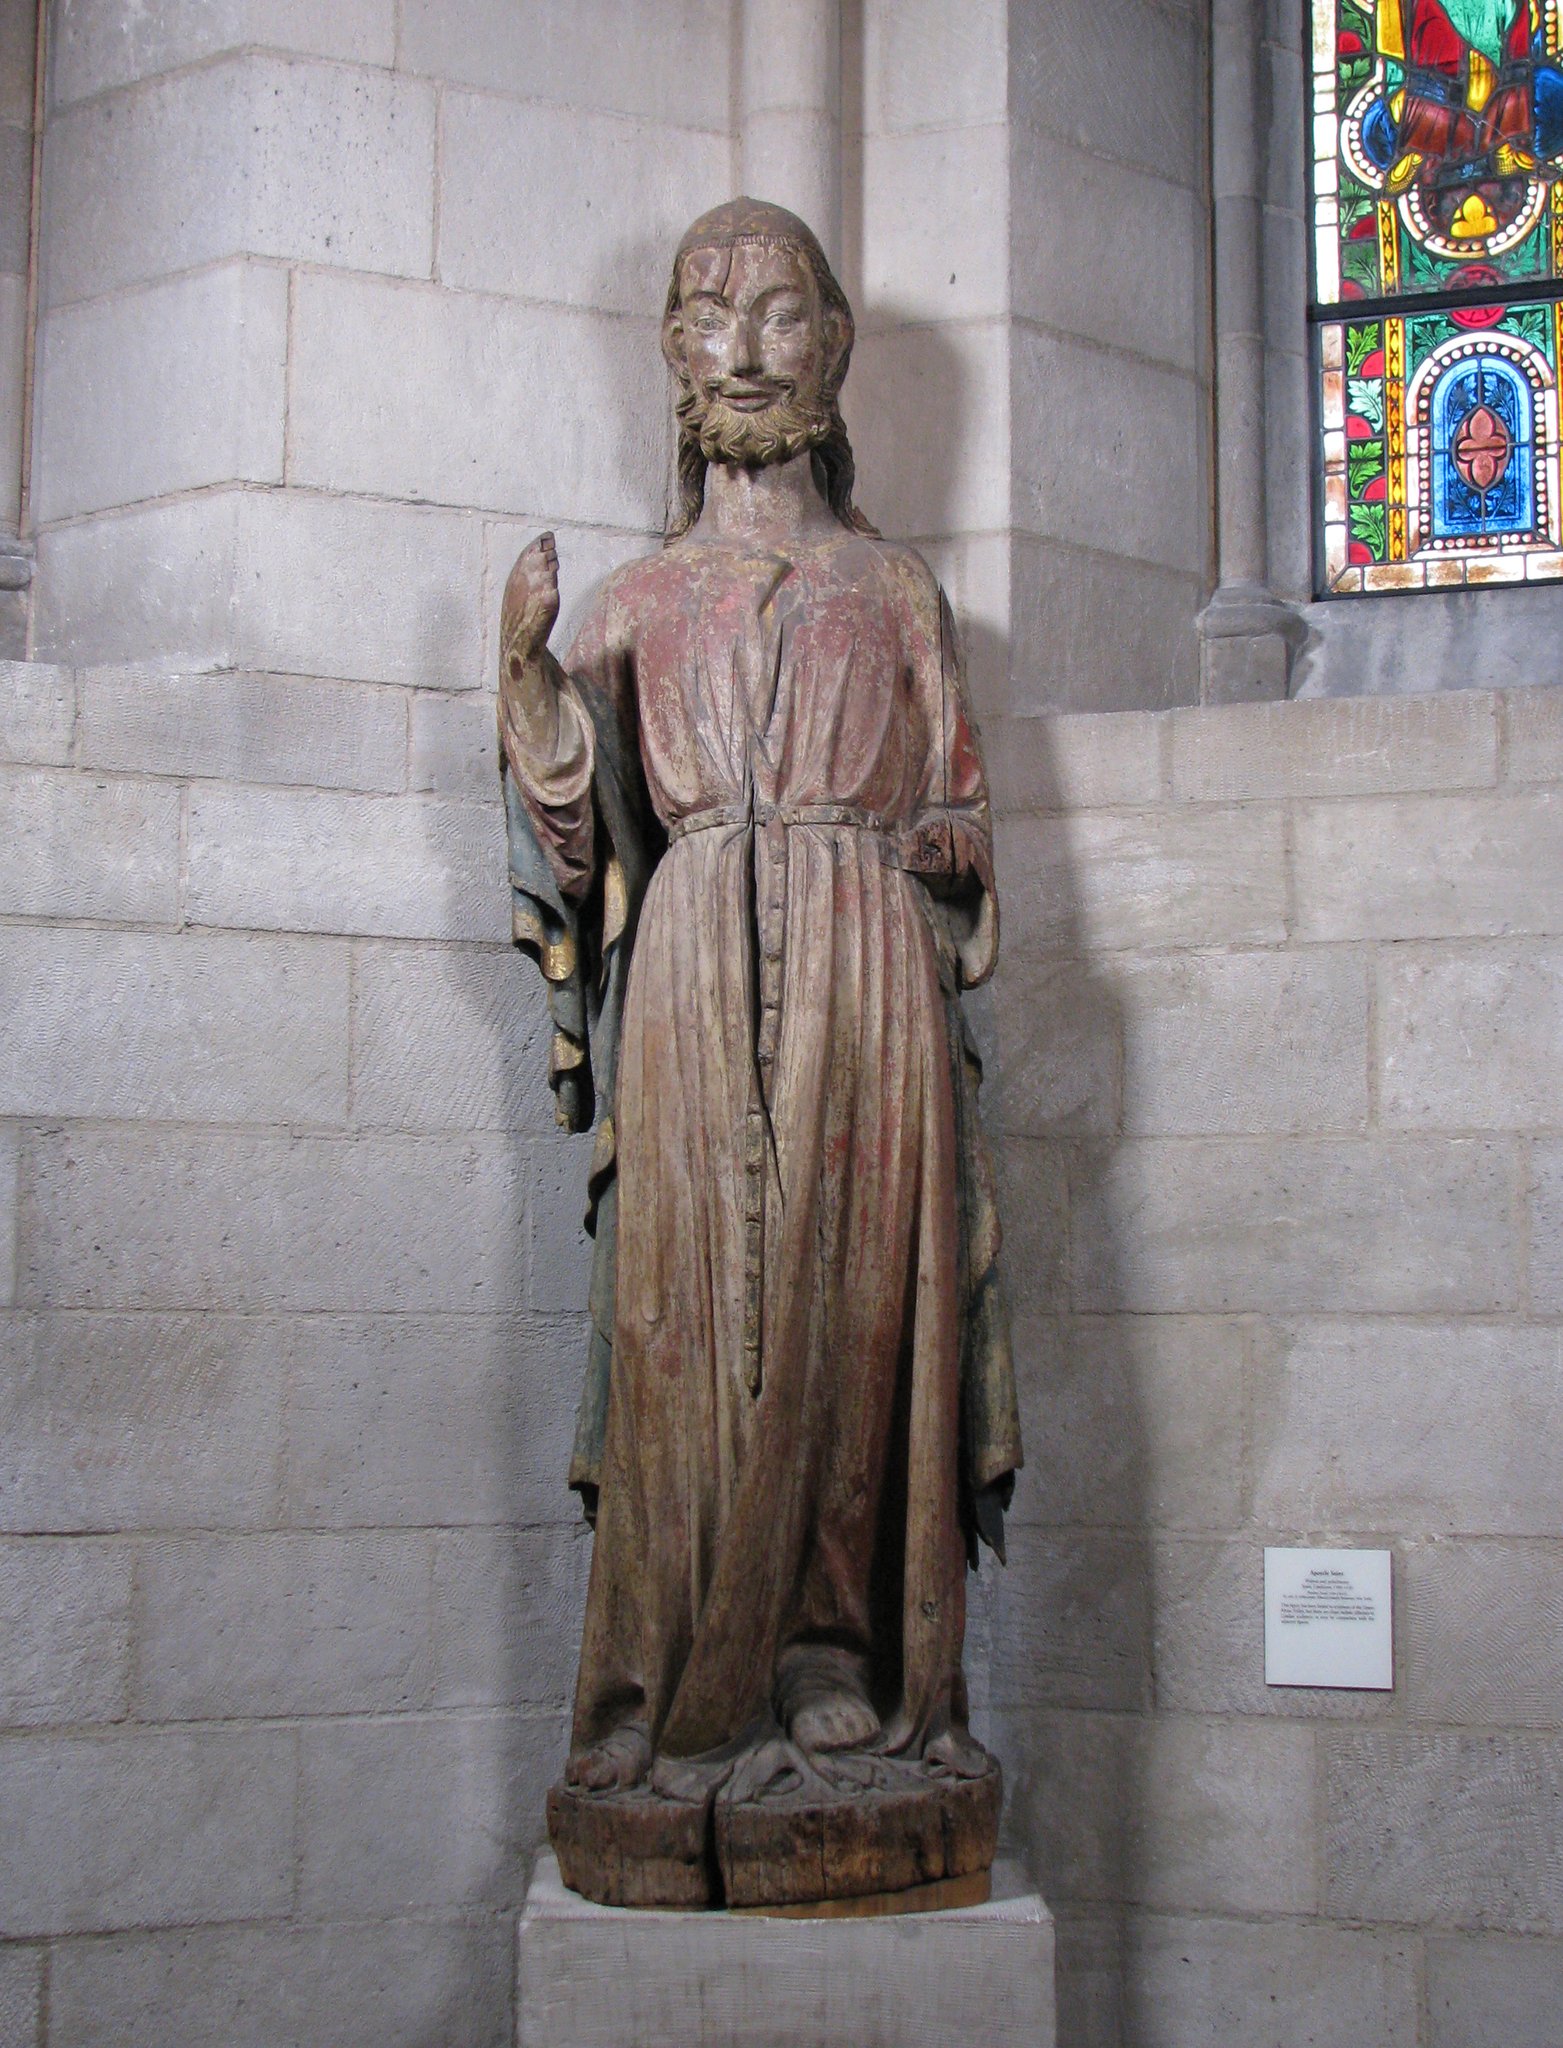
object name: statue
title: Saint James the Lesser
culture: german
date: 1201-1300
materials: canvas, gesso, wood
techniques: painting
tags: saints